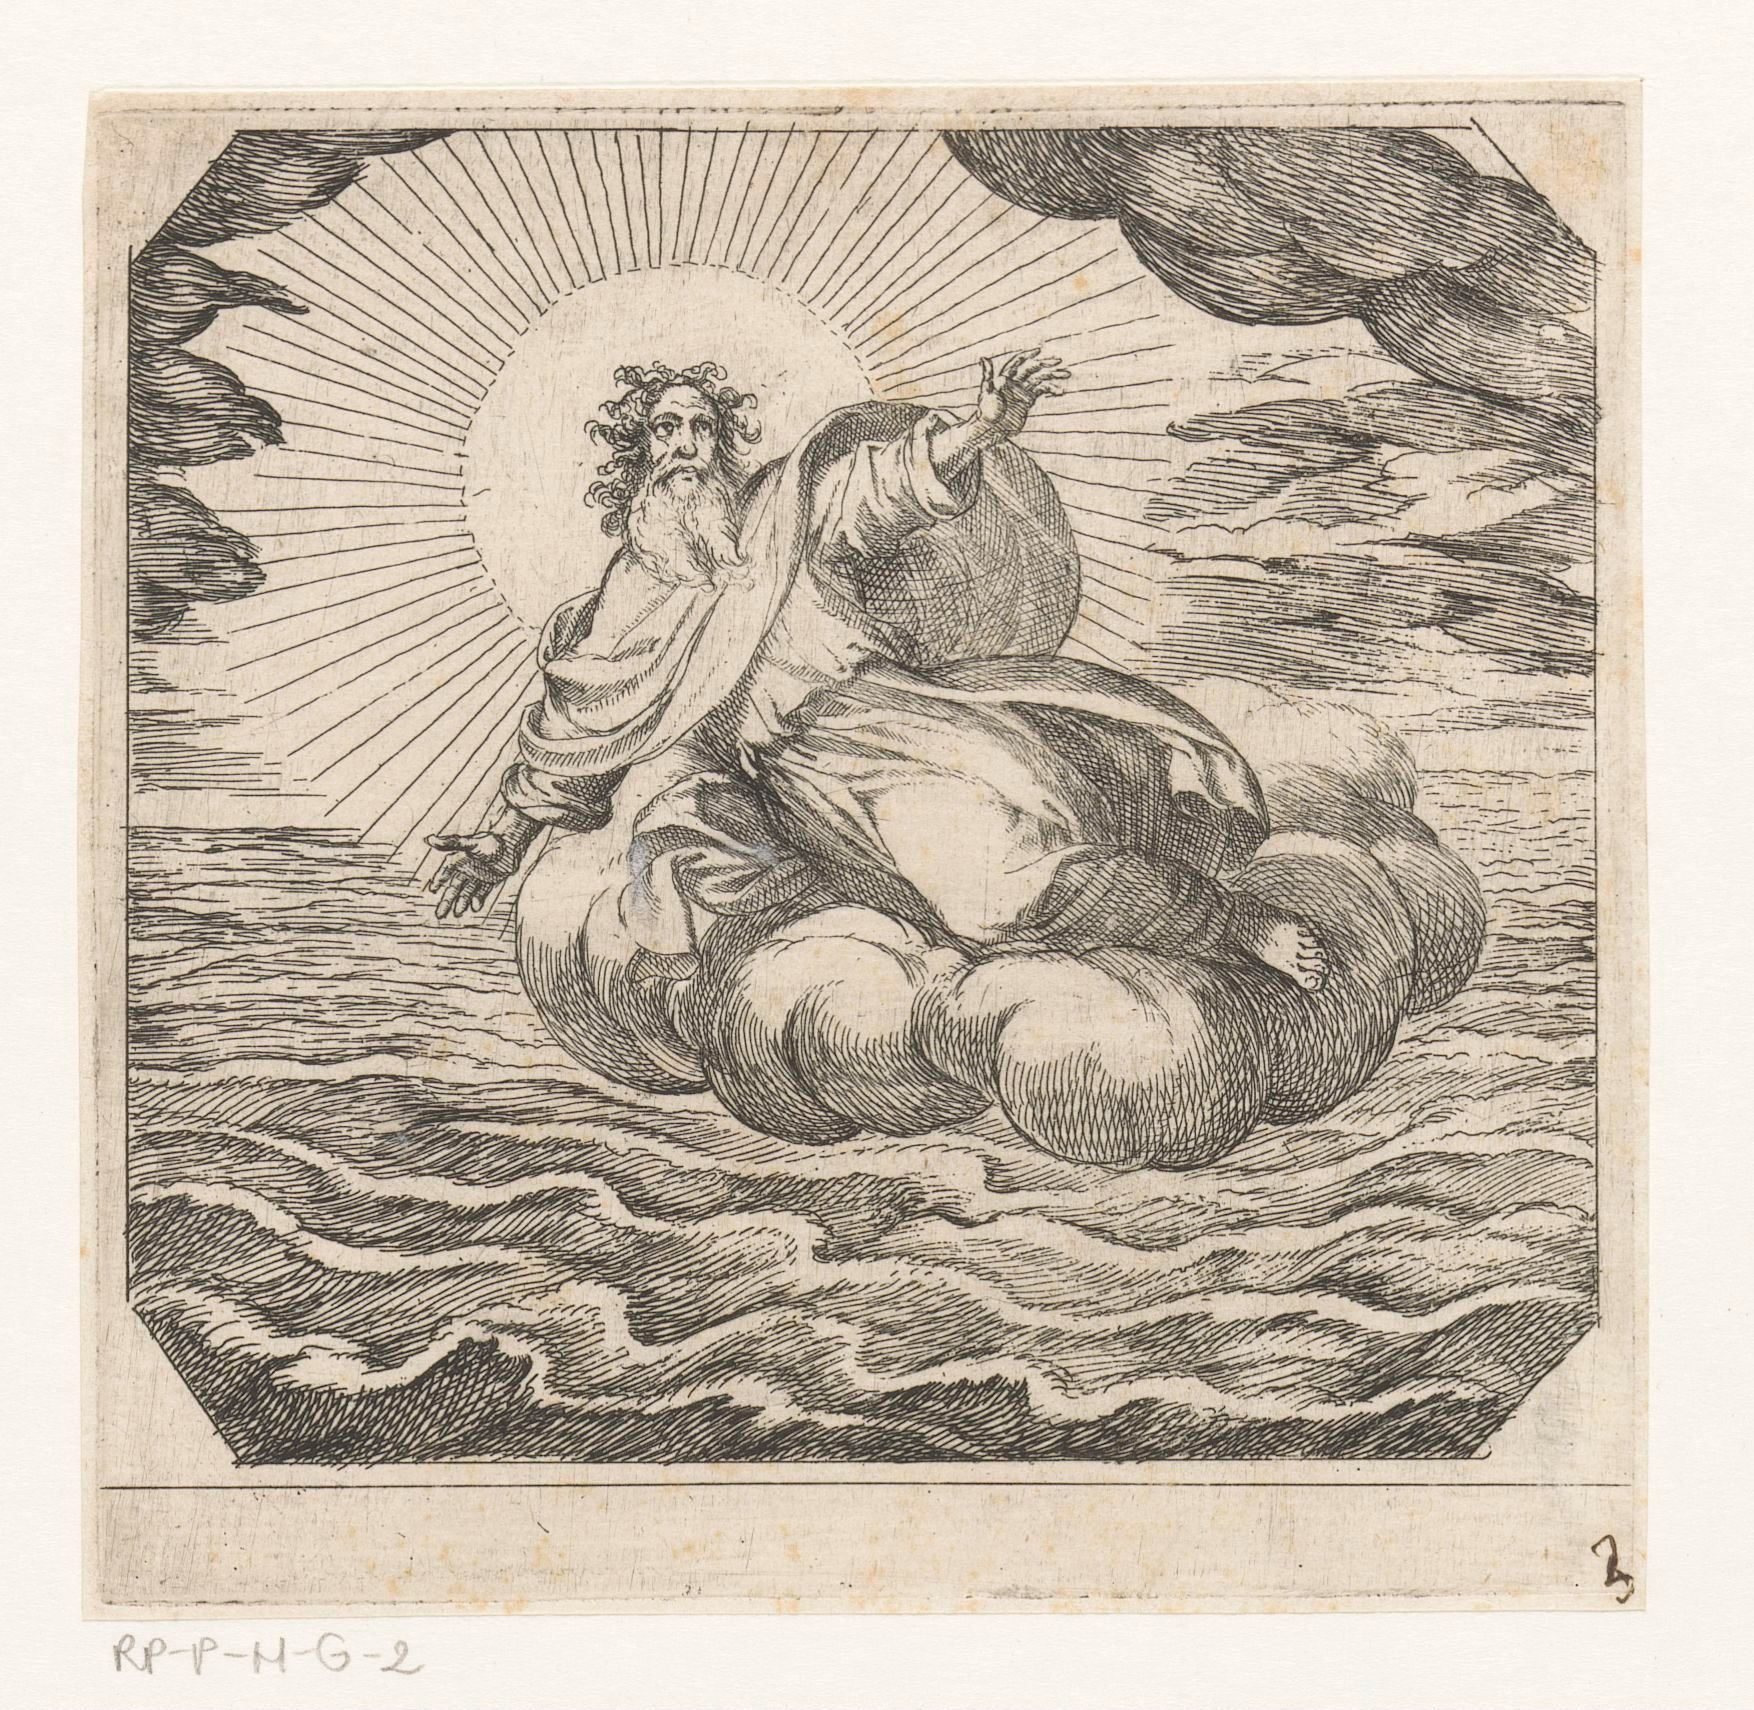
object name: print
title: God schept hemel en aarde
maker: antonio tempesta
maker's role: draughtsman, painter, print maker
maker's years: 1555-1630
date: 1565-1630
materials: paper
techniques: etching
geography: vatican city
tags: division of light and darkness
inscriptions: number: ‘3’, collector's mark: ‘Hinloopen’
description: Deze prent maakt deel uit van een serie van twaalf prenten van de schepping. De prenten zijn deels naar ontwerpen van Rafaël voor de Loggia van Rafaël in het Vaticaan, en deels naar prenten door Nicolaes de Bruyn naar ontwerpen van Maerten de Vos (zie: Holl. Dutch. vol. 45 nr. 1-10).